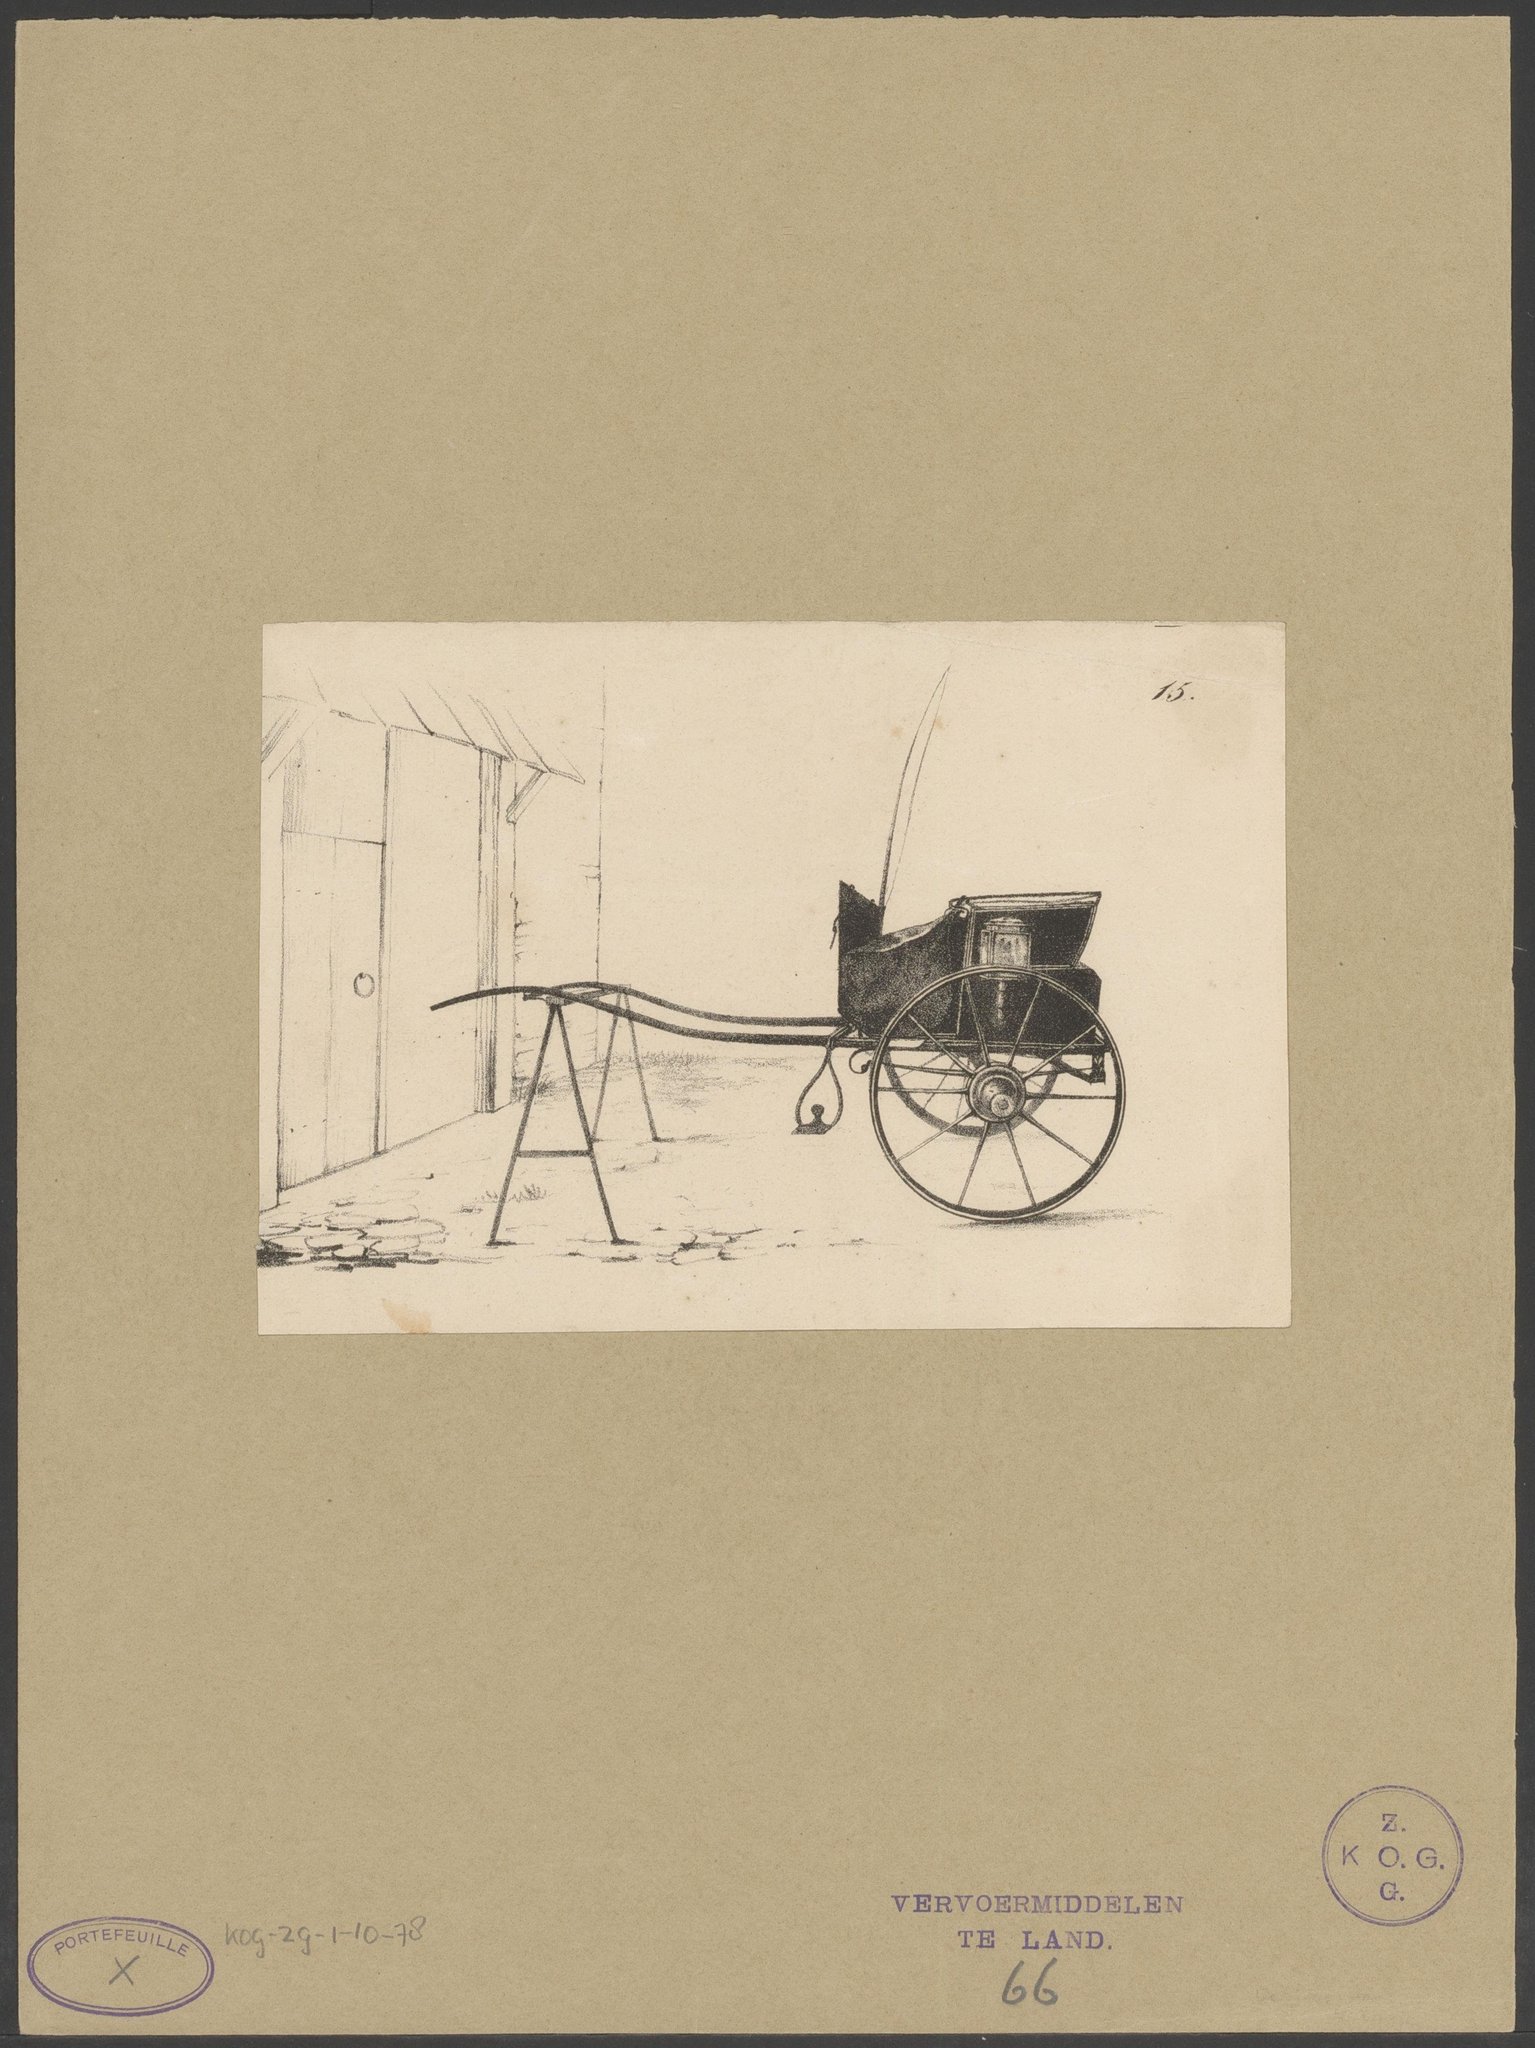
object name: print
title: Wagen met twee wielen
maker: Anonymous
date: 1795-1899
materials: paper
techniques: lithograph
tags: two-wheeled, animal-drawn vehicle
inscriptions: stamp, stamp, collector's mark: Lugt 1641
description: Rechtsboven genummerd: 15. Onderwerpsrubrieken binnen de Atlas Zeden en Gewoonten: Handel, nijverheid en verkeer, Vervoermiddelen te land en te water, vervoermiddelen te land, Rijtuigen en Statiekarossen.